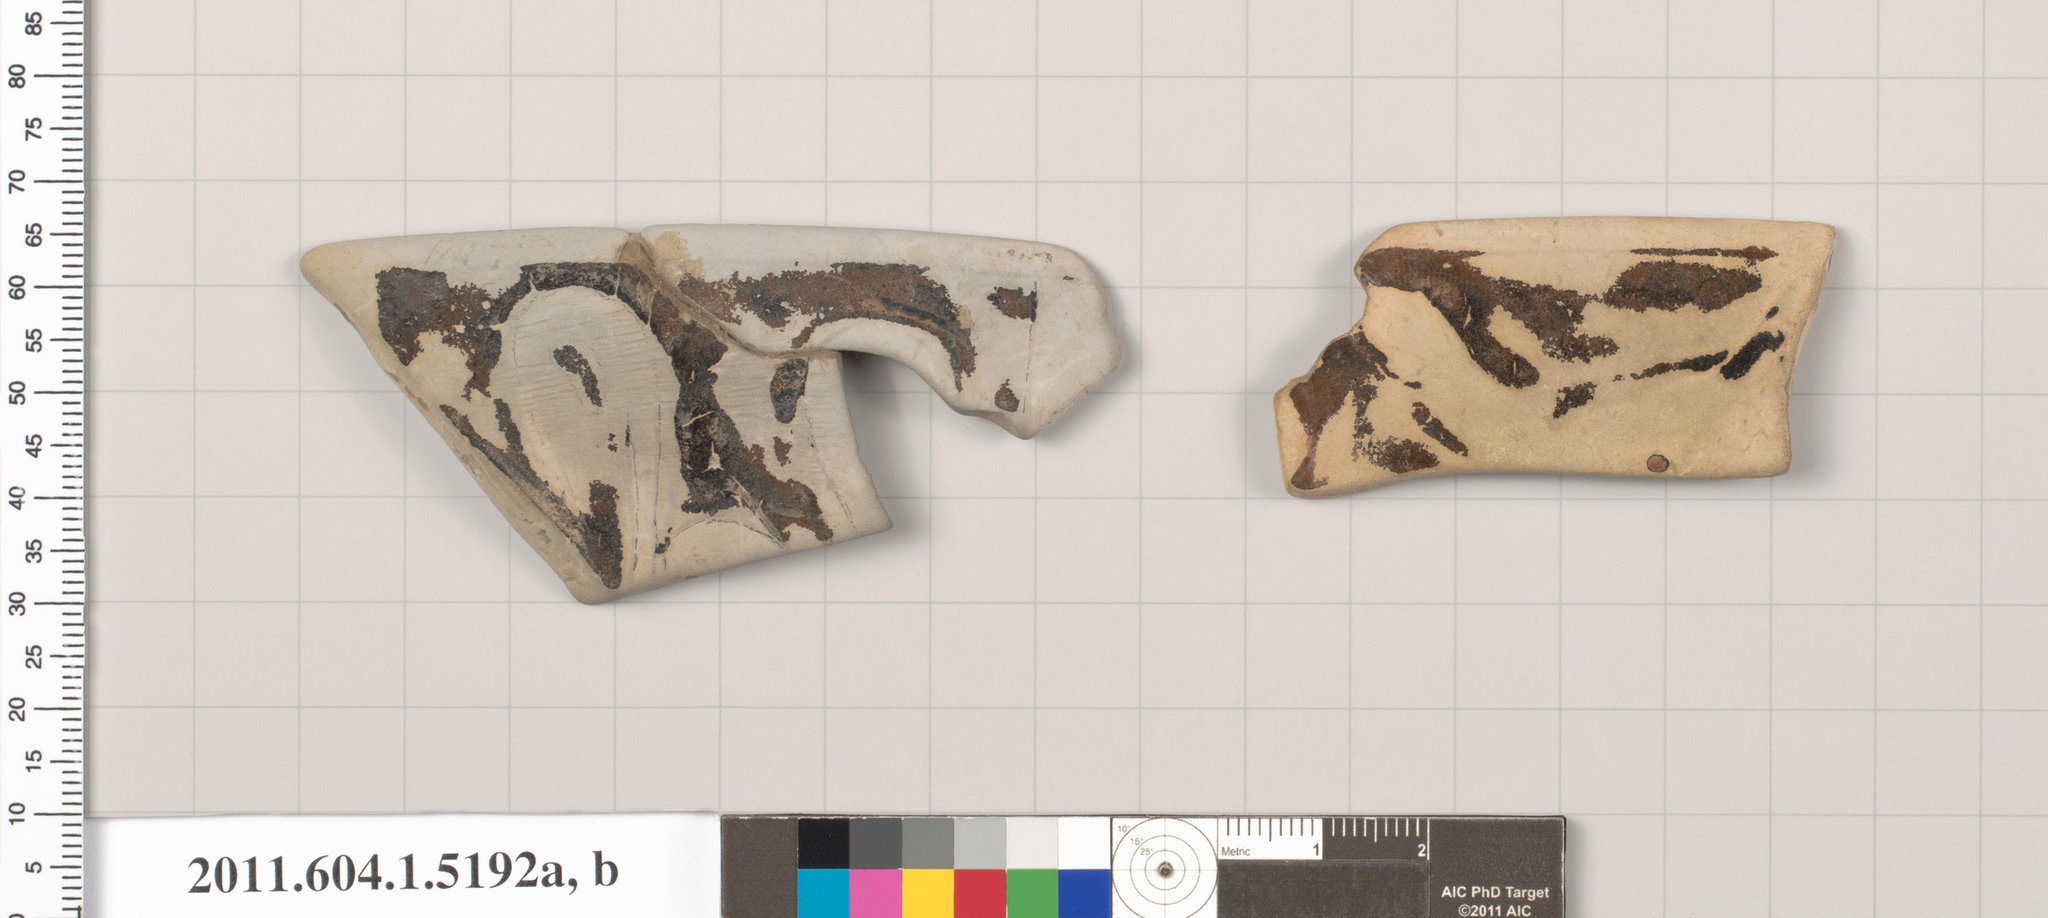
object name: kylix fragment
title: Terracotta rim fragments of a kylix (drinking cup)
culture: greek, attic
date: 500-480 BCE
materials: terracotta